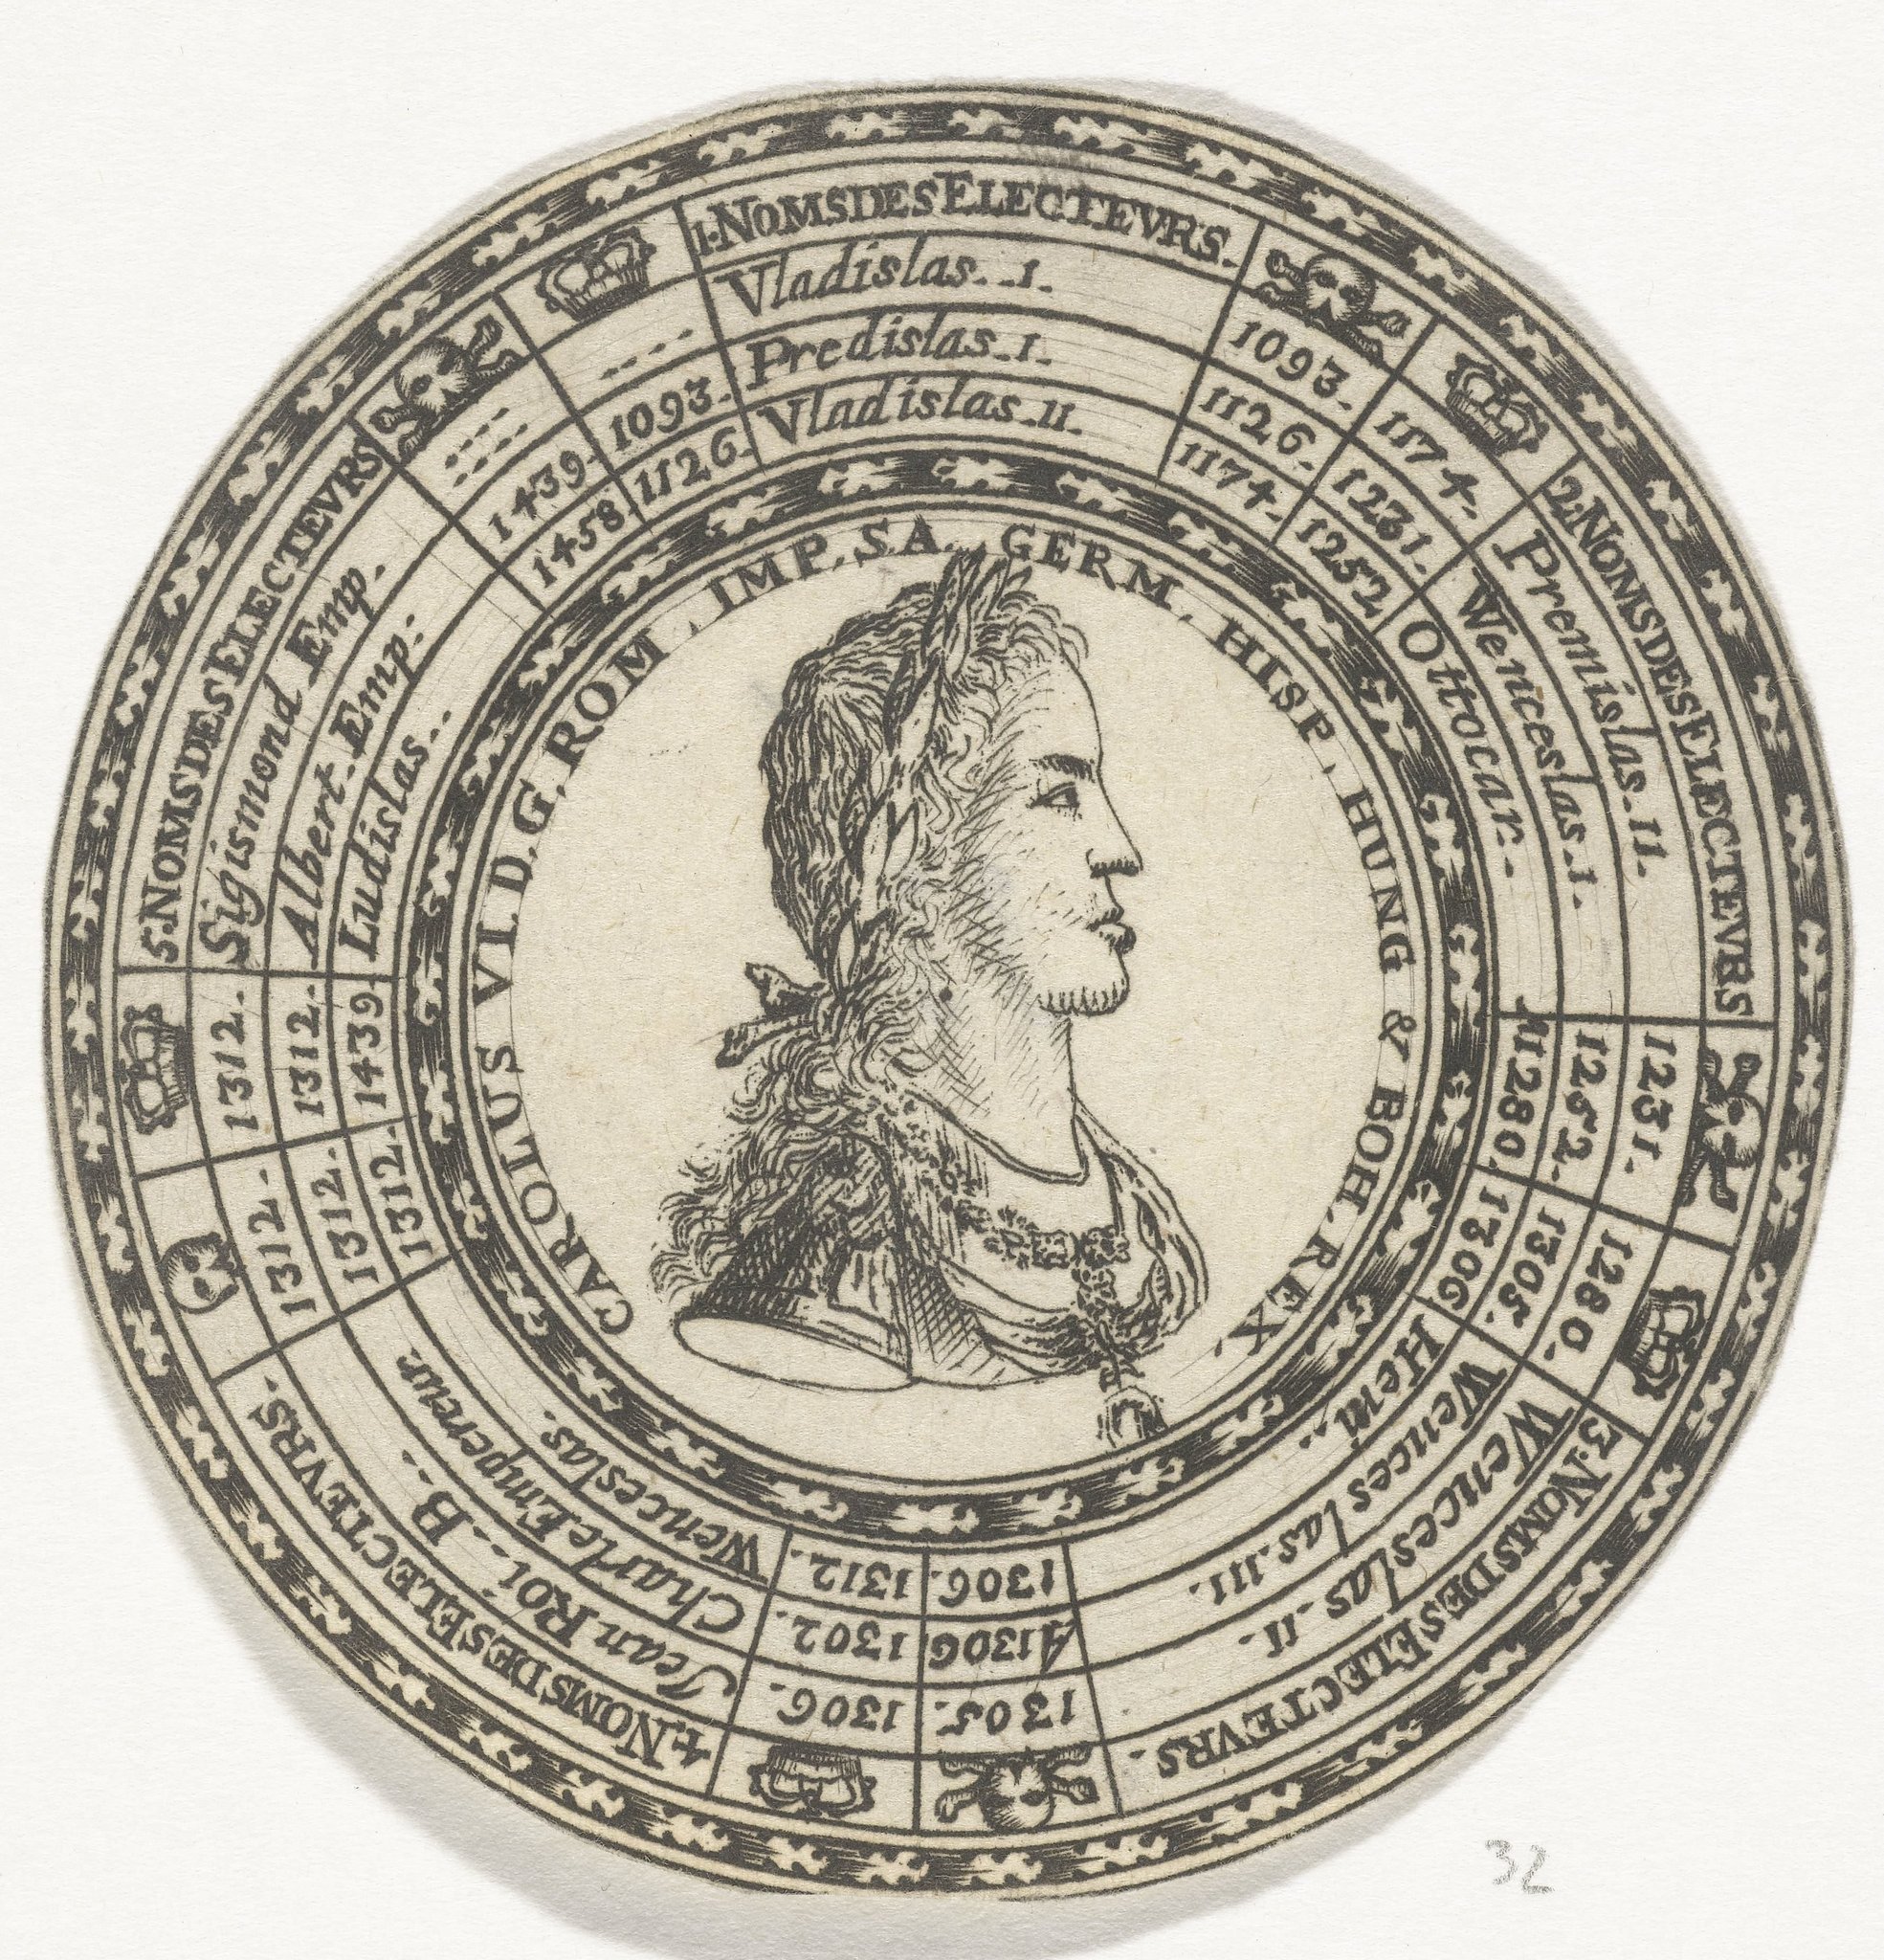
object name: print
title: Penning met het portret van keizer Karel VI en de namen van de Boheemse koningen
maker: Anonymous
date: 1711-1720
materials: paper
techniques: etching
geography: amsterdam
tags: vienna, charles vi (holy roman emperor), king, seal (symbol of sovereignty)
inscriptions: number: ‘33’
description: Ontwerp van een ronde penning met, in vier concentrische cirkels, de namen van de koningen van Bohemen en hun regeringsjaren, beginnende bij koning Vratislav II en eindigend bij Ladislaus van Bohemen. In het midden van de penning het portret van koning Karel VI van Bohemen.